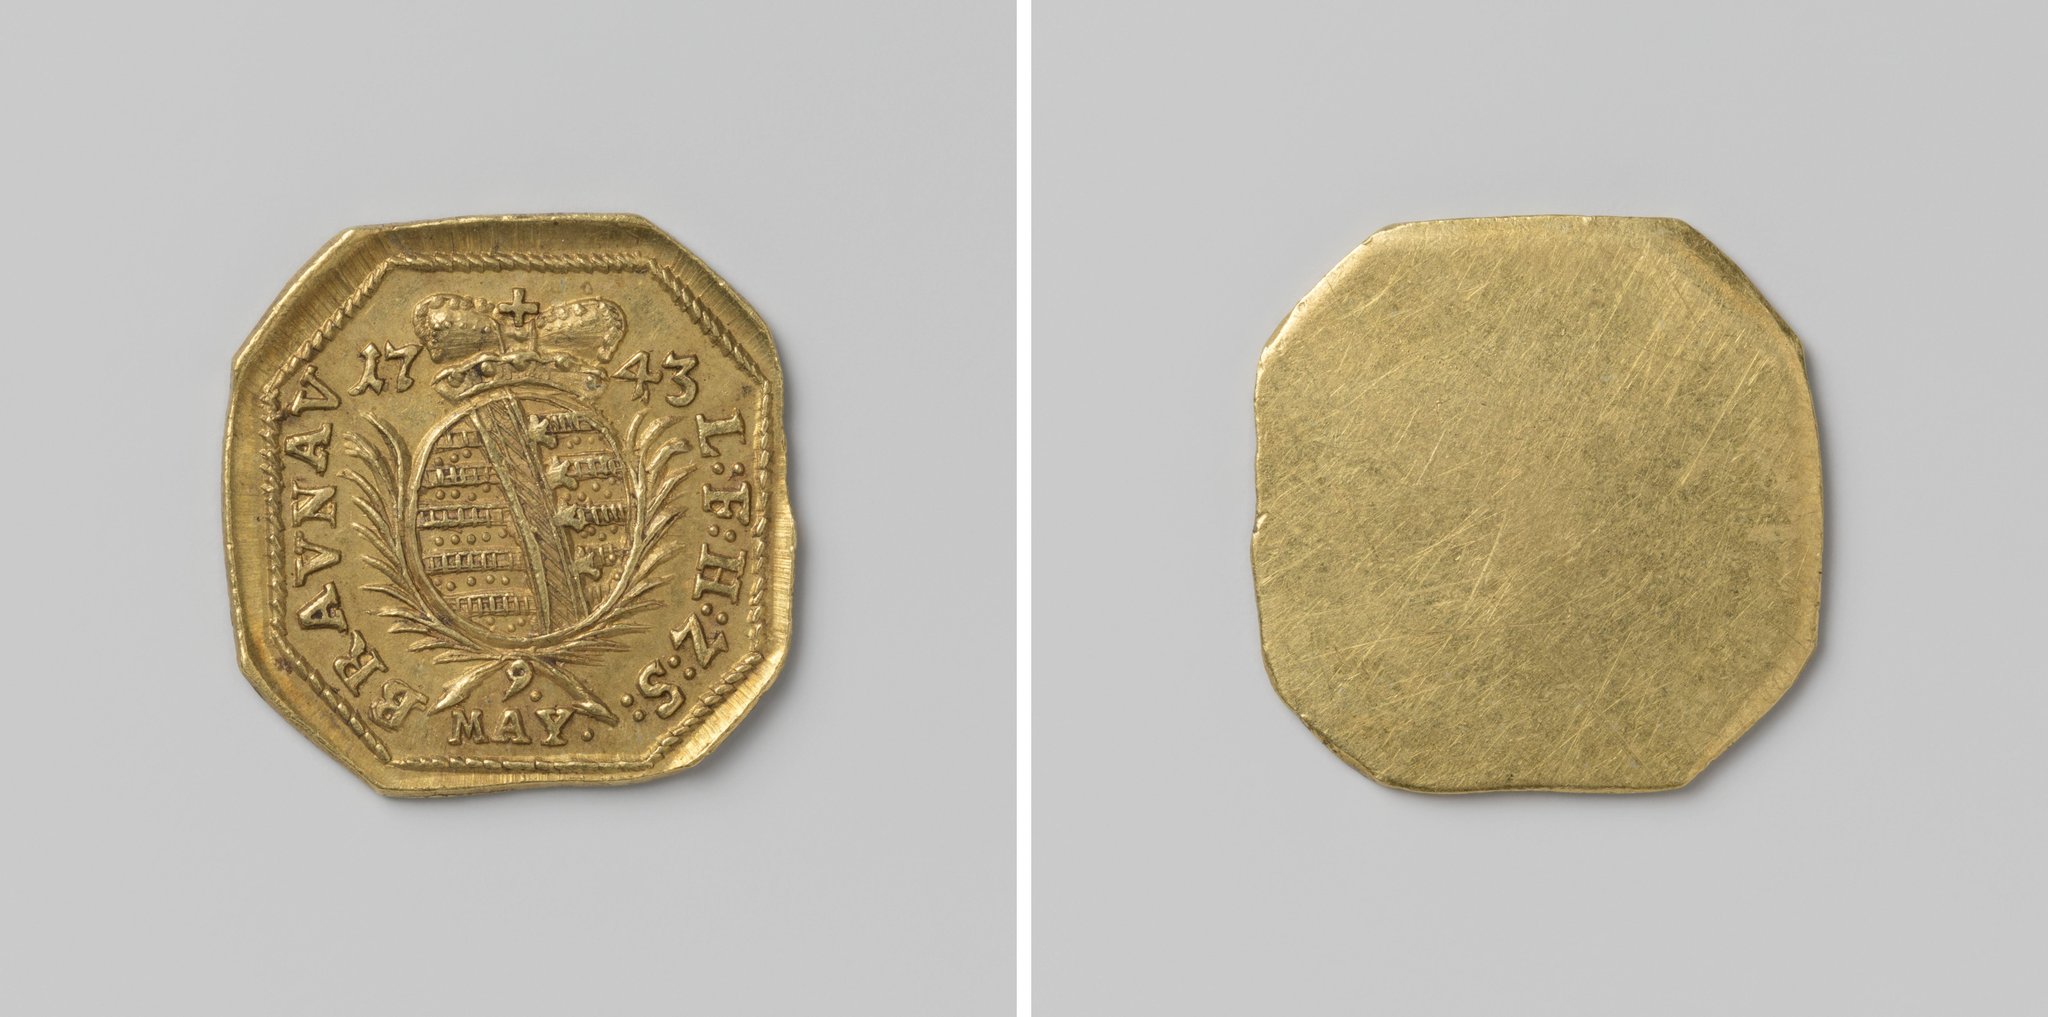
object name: ducat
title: Dukaat, noodmunt uit Braunau, geslagen tijdens het beleg door de Oostenrijkers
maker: Anonymous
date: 1743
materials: gold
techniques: striking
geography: braunau-am-inn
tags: braunau-am-inn, beleg van braunau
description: eenzijdige, vierkante noodmunt met afgeschuinde hoeken. Voorzijde: gekroond wapenschild tussen jaartal binnen bladerkrans en omschrift. Keerzijde: blanco